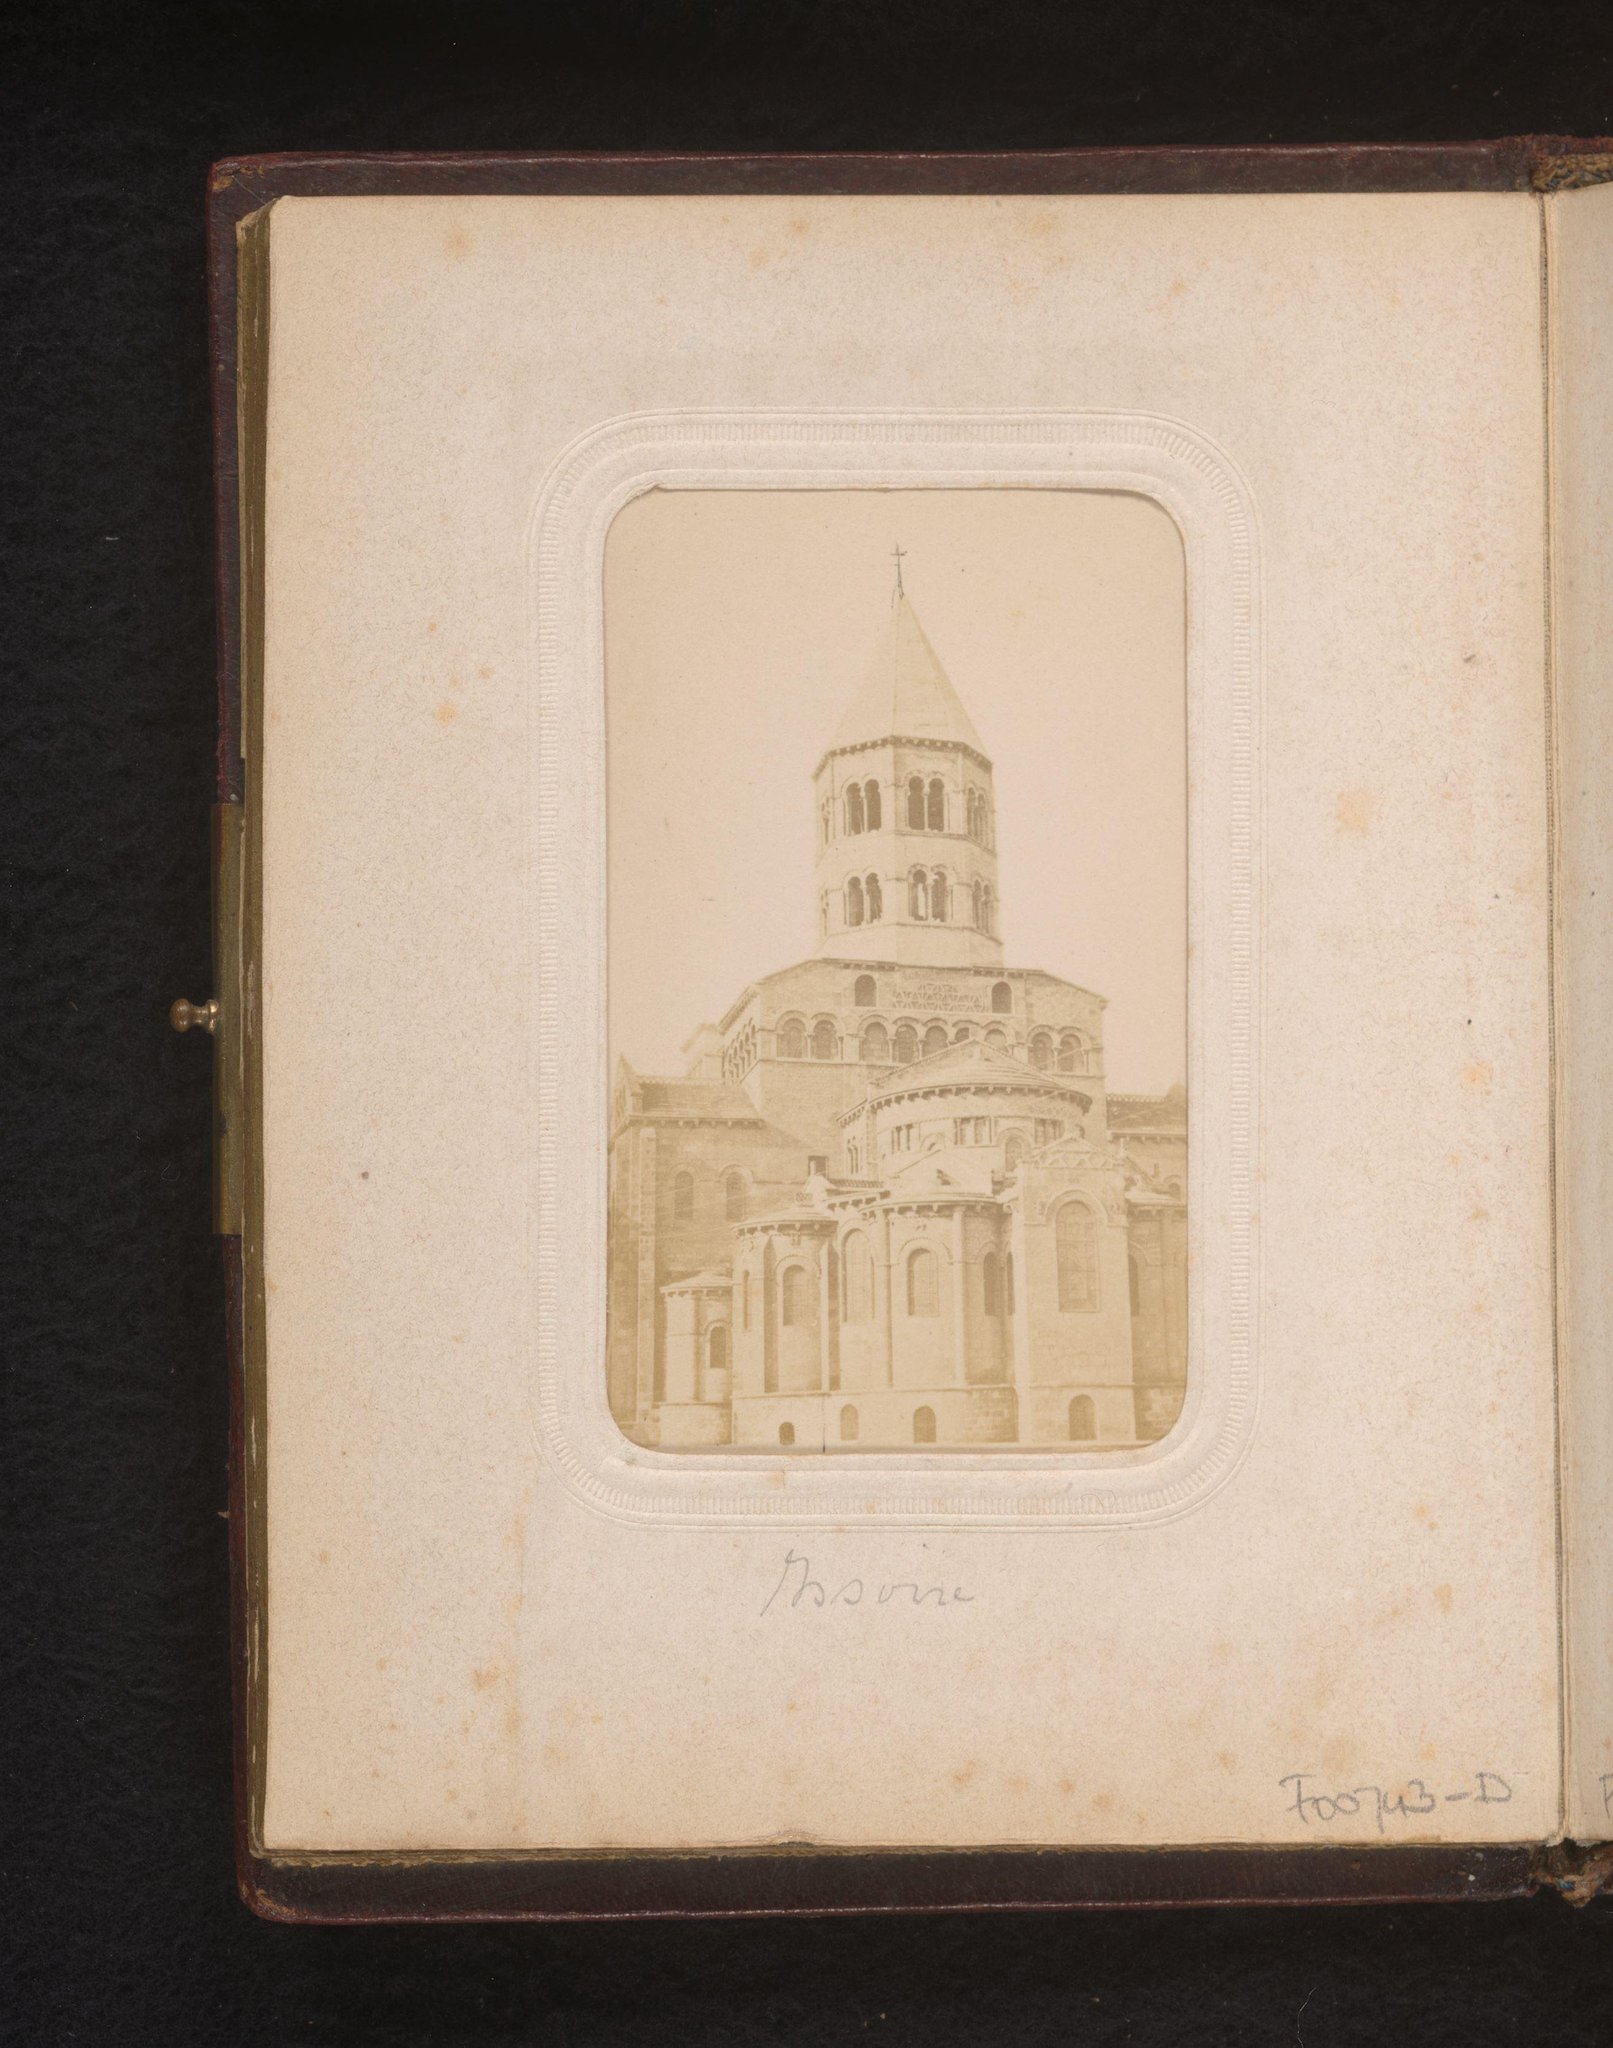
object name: photograph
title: Gezicht op een kerk in Issoire, Frankrijk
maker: toulot-laroche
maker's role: fotograaf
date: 1860-1880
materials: cardboard, photographic support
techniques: albumen print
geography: issoire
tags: church (exterior)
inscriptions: inscription: ‘TOULOT-LAROCHE/ PHOTOGRAPHE/ Boulevard de la Halle./ ISSOIRE’, annotation: ‘Issoire’